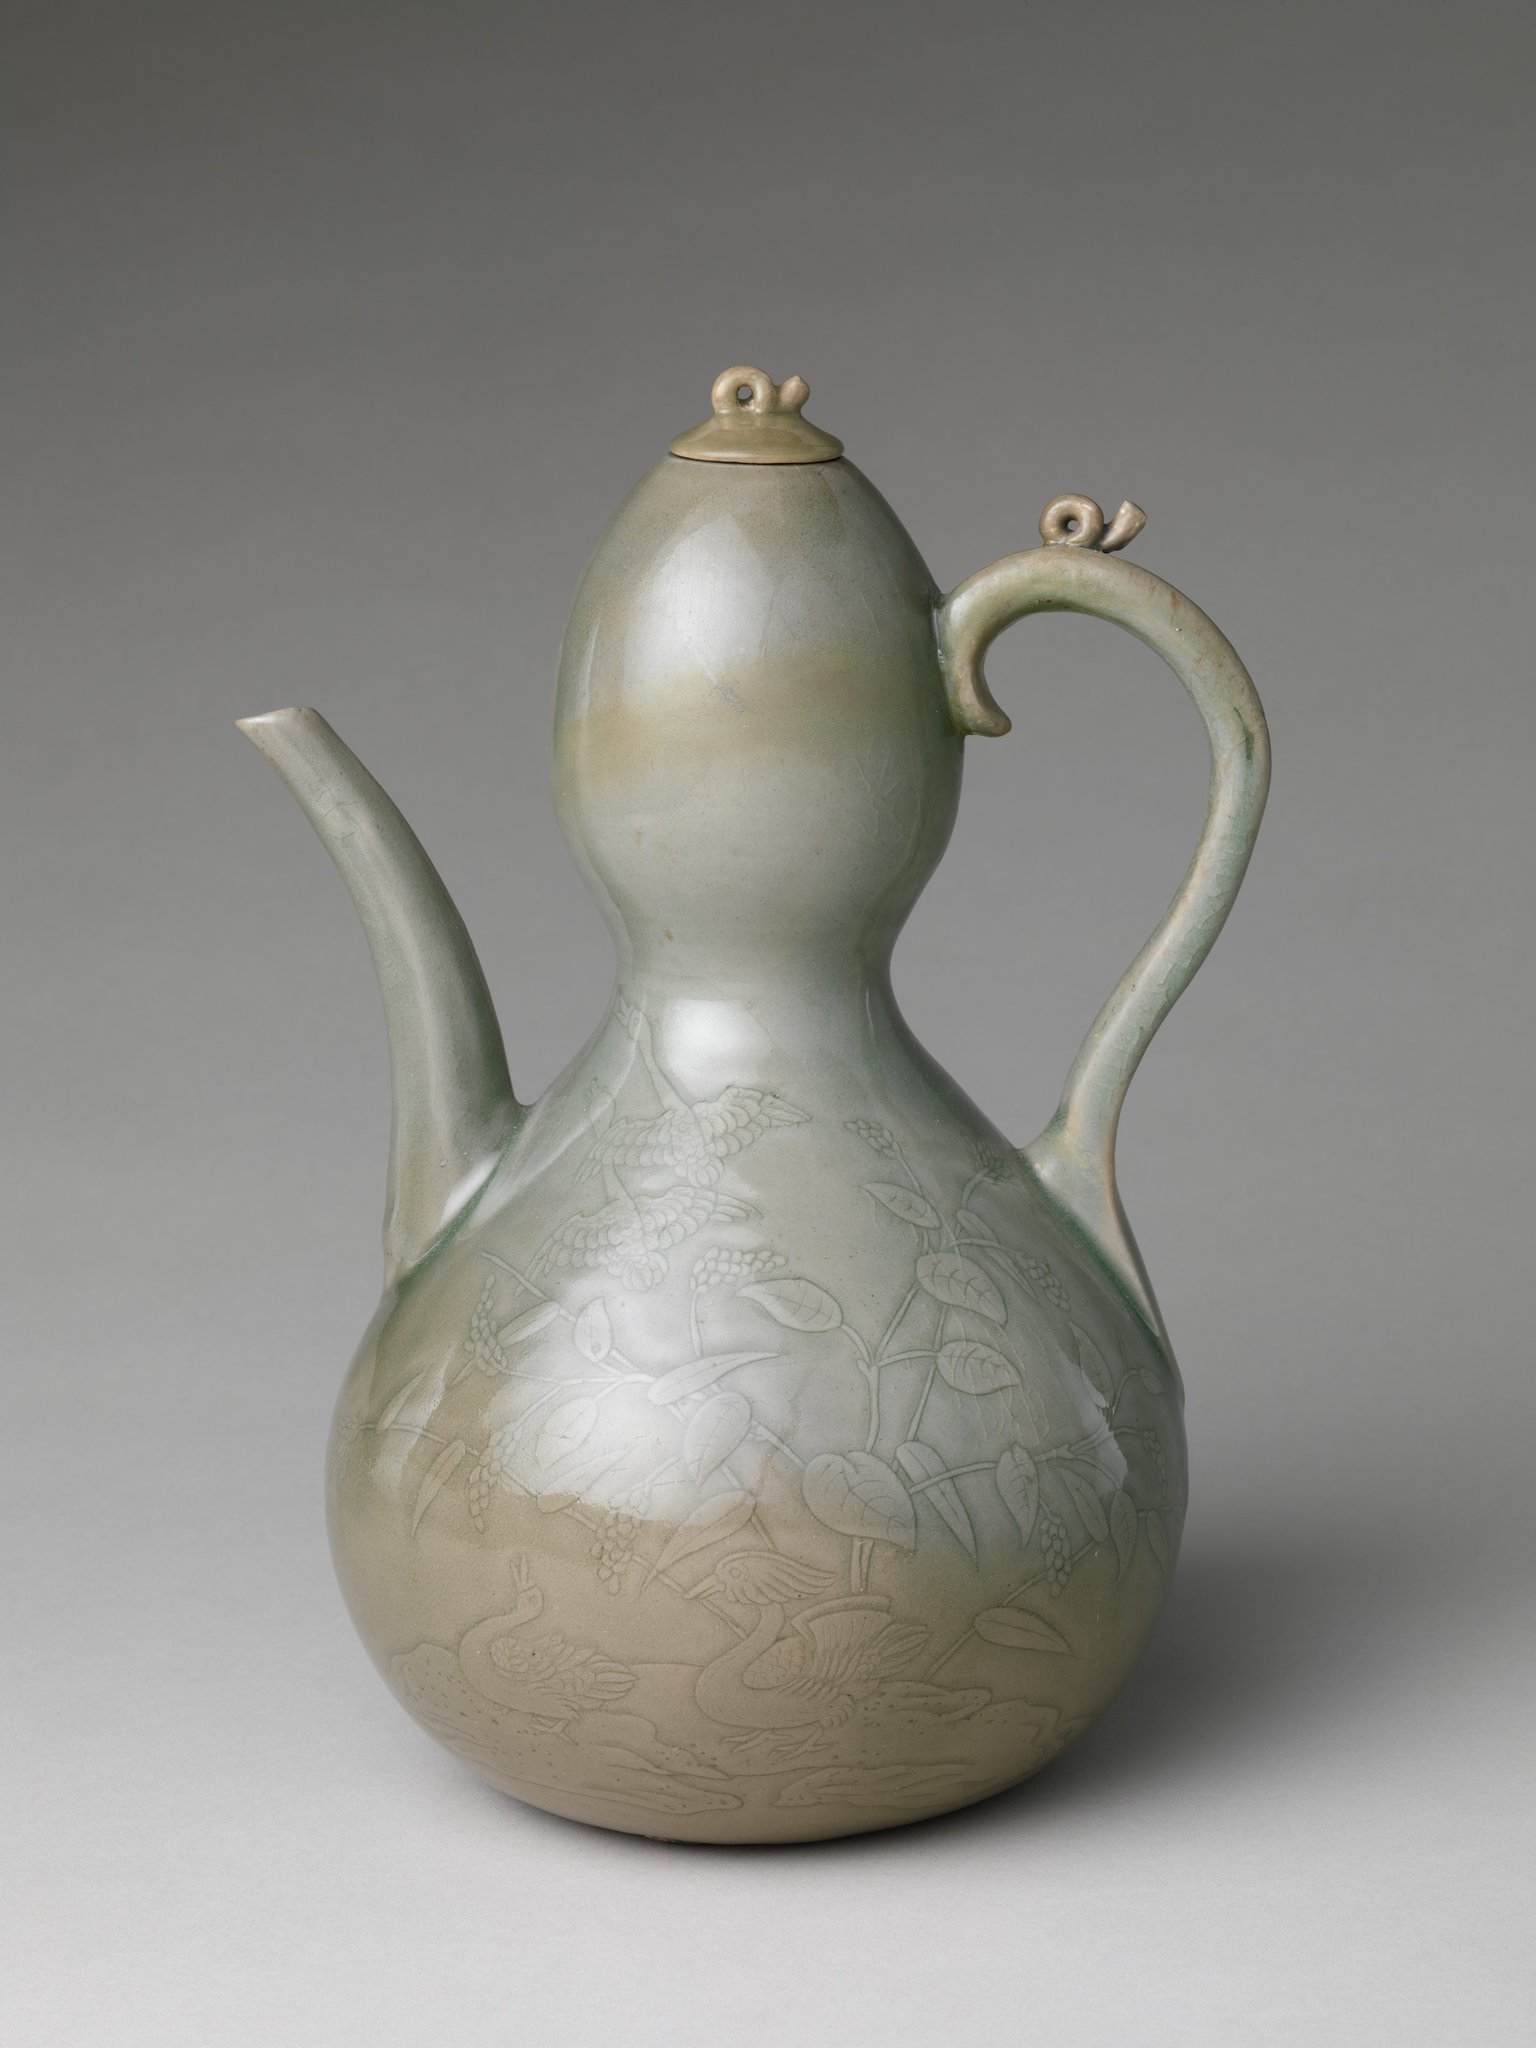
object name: ewer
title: Gourd-shaped ewer decorated with waterfowl and reeds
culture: korean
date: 1101-1133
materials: ceramic glaze, glaze, stoneware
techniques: carving, incising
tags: birds